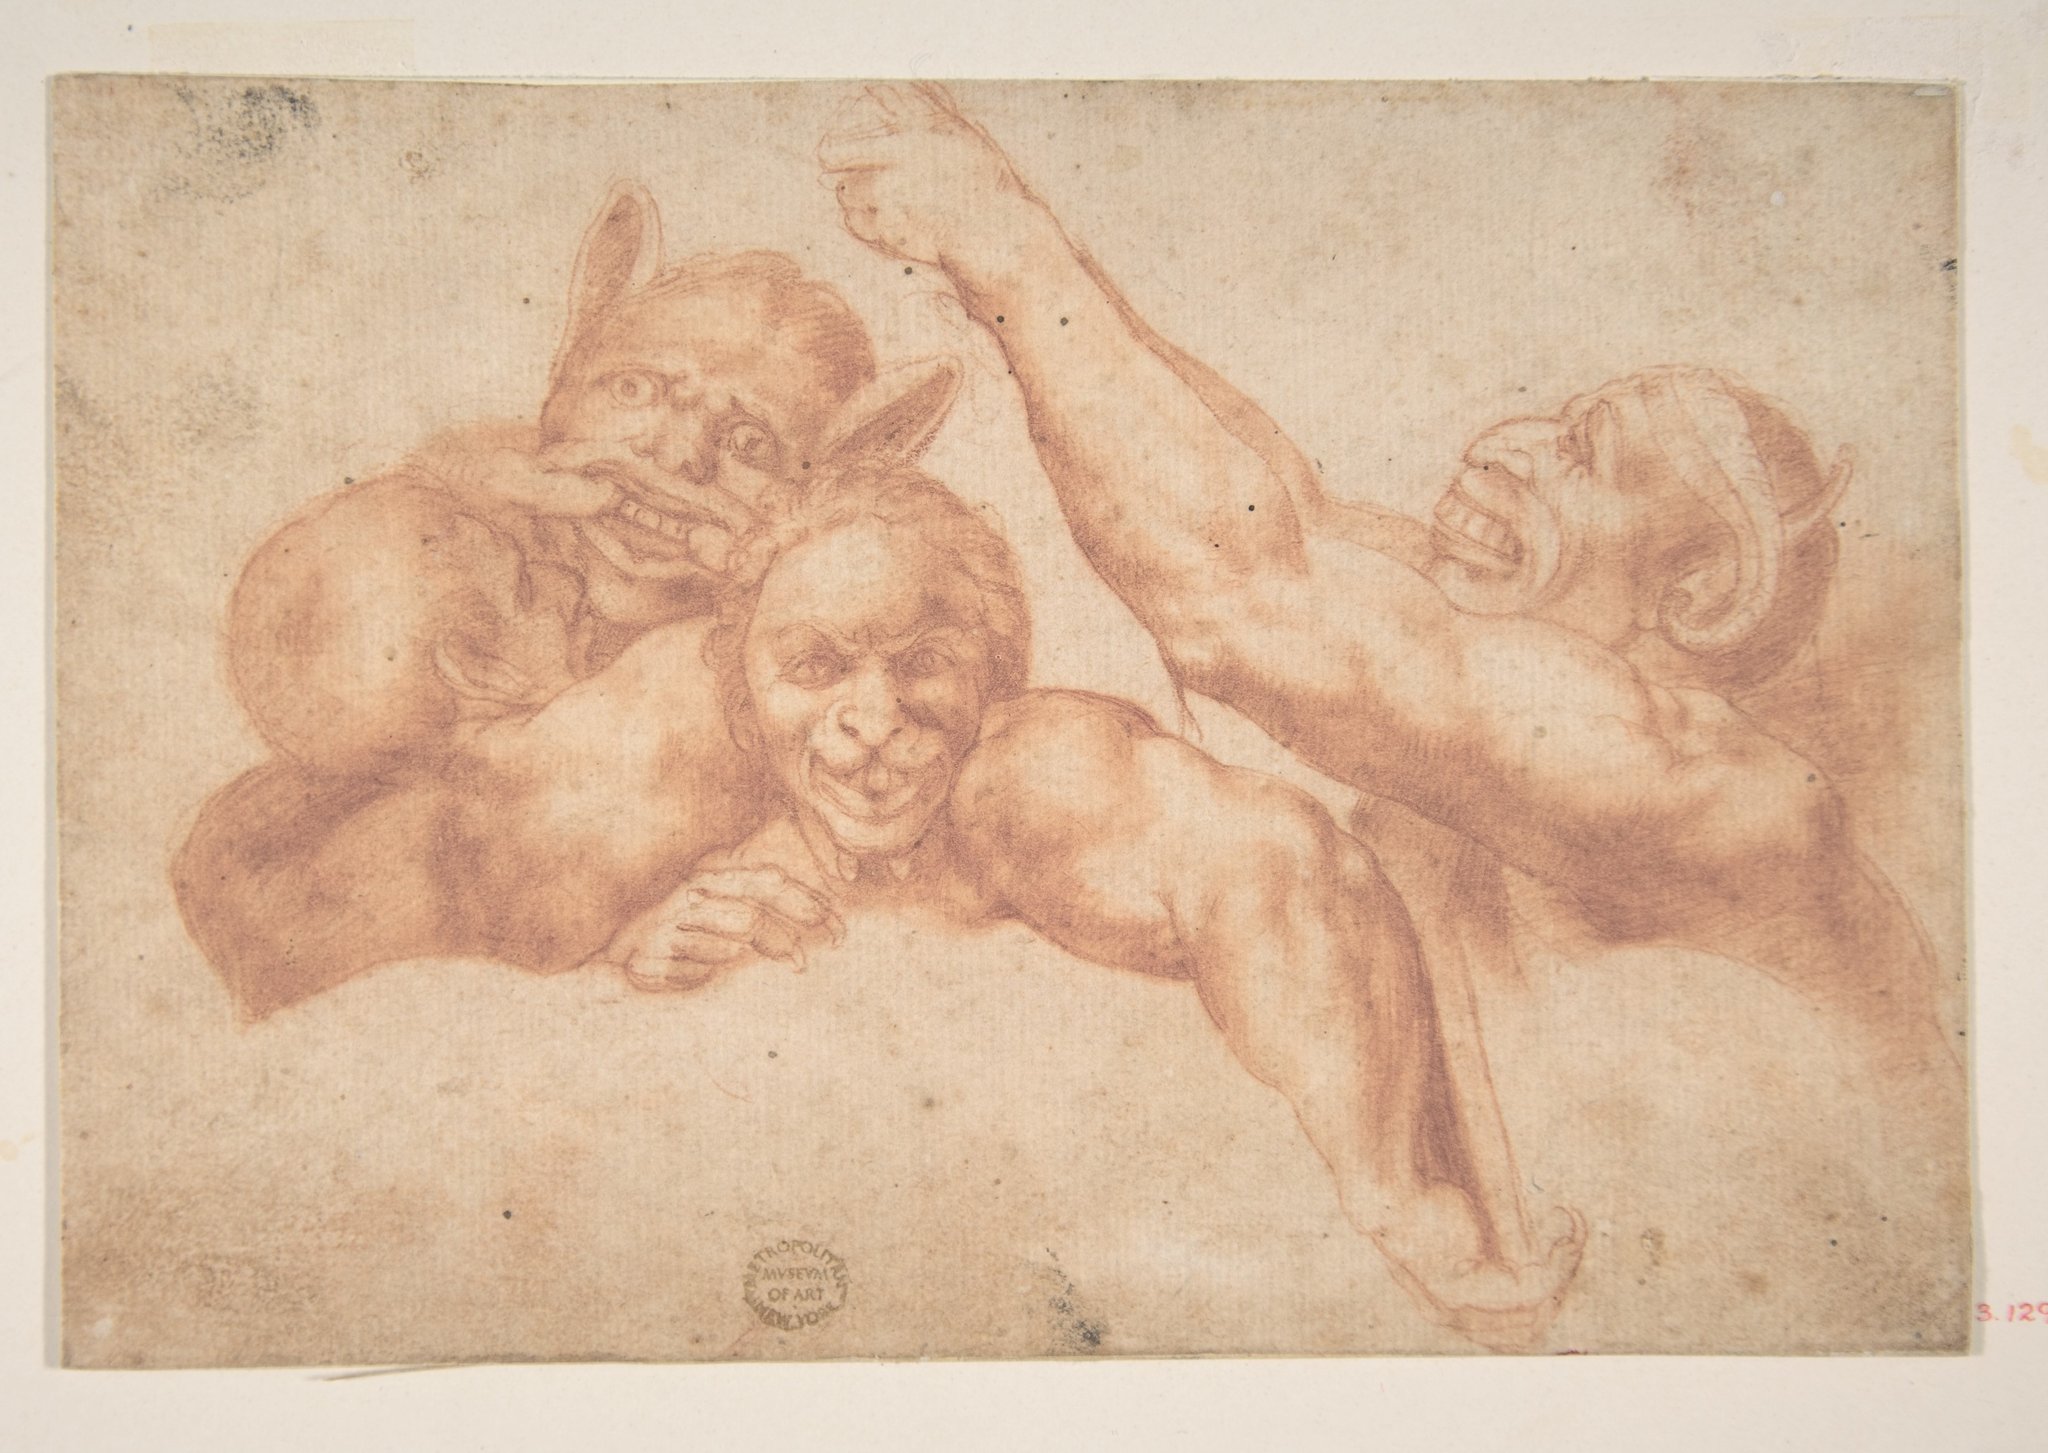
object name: drawing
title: Study of Figures from Michelangelo's Last Judgment, Sistine Chapel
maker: michelangelo buonarroti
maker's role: artist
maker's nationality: italian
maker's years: 1475-1564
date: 1540-1550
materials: chalk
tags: last judgement